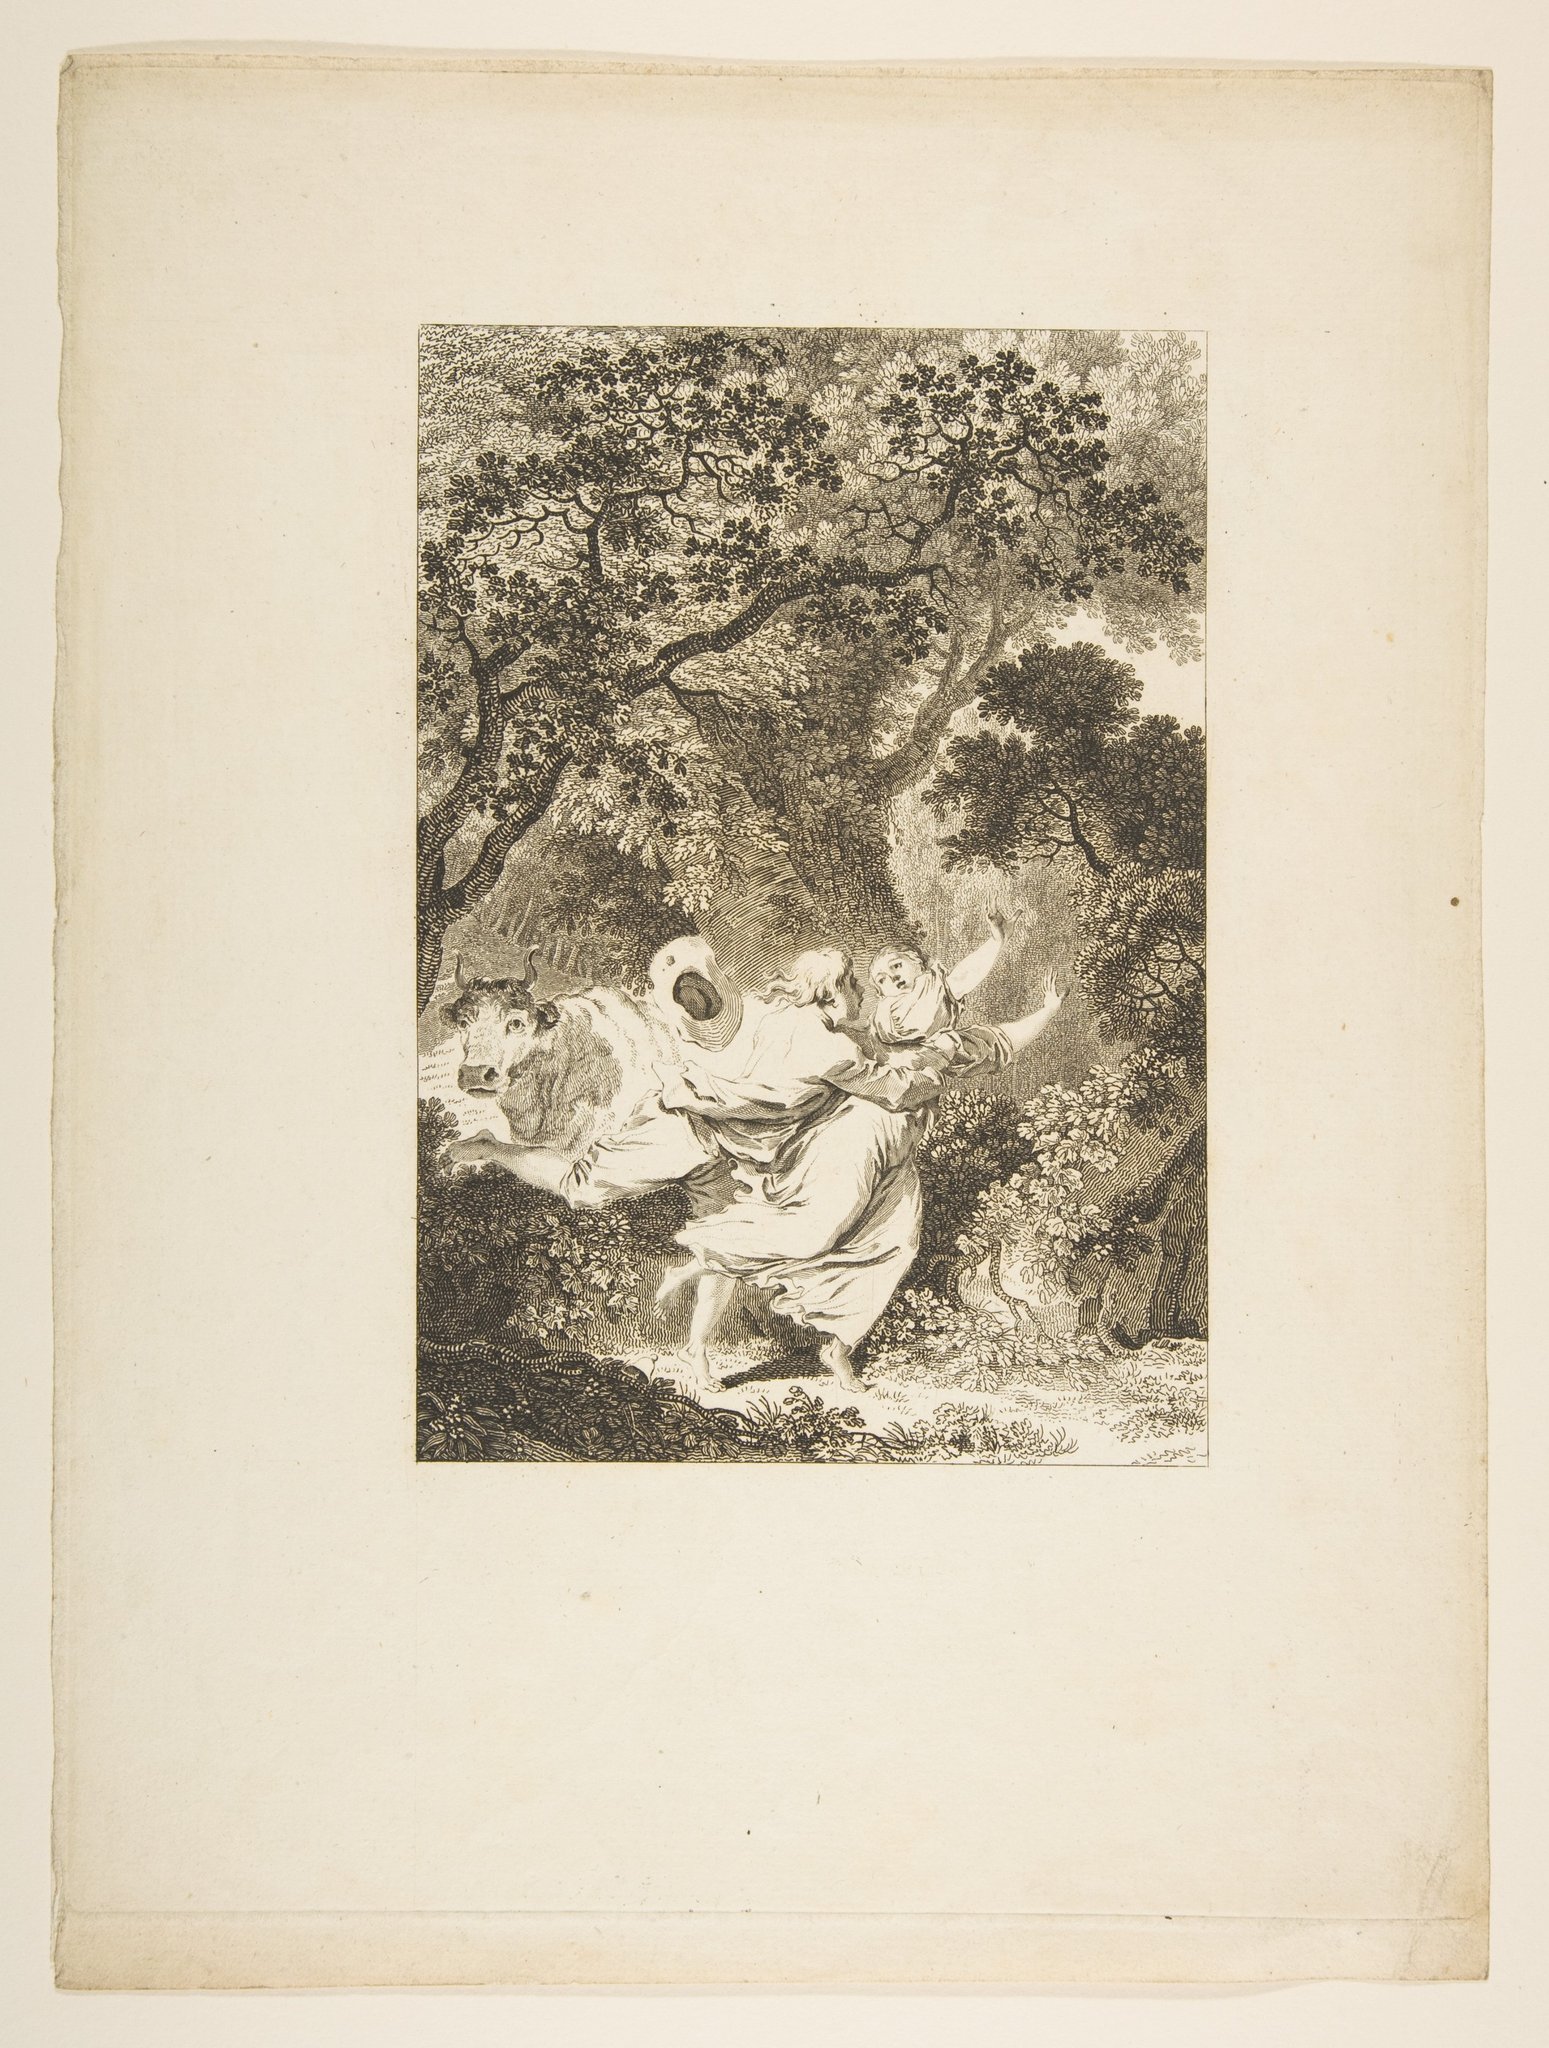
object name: print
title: La Clochette, from "Contes et nouvelles en vers par Jean de La Fontaine. A Paris, de l'imprimerie de P. Didot, l'an III de la République, 1795"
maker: jean dambrun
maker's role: artist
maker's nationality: french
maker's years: 1741-1808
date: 1795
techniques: etching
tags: men,women,cows